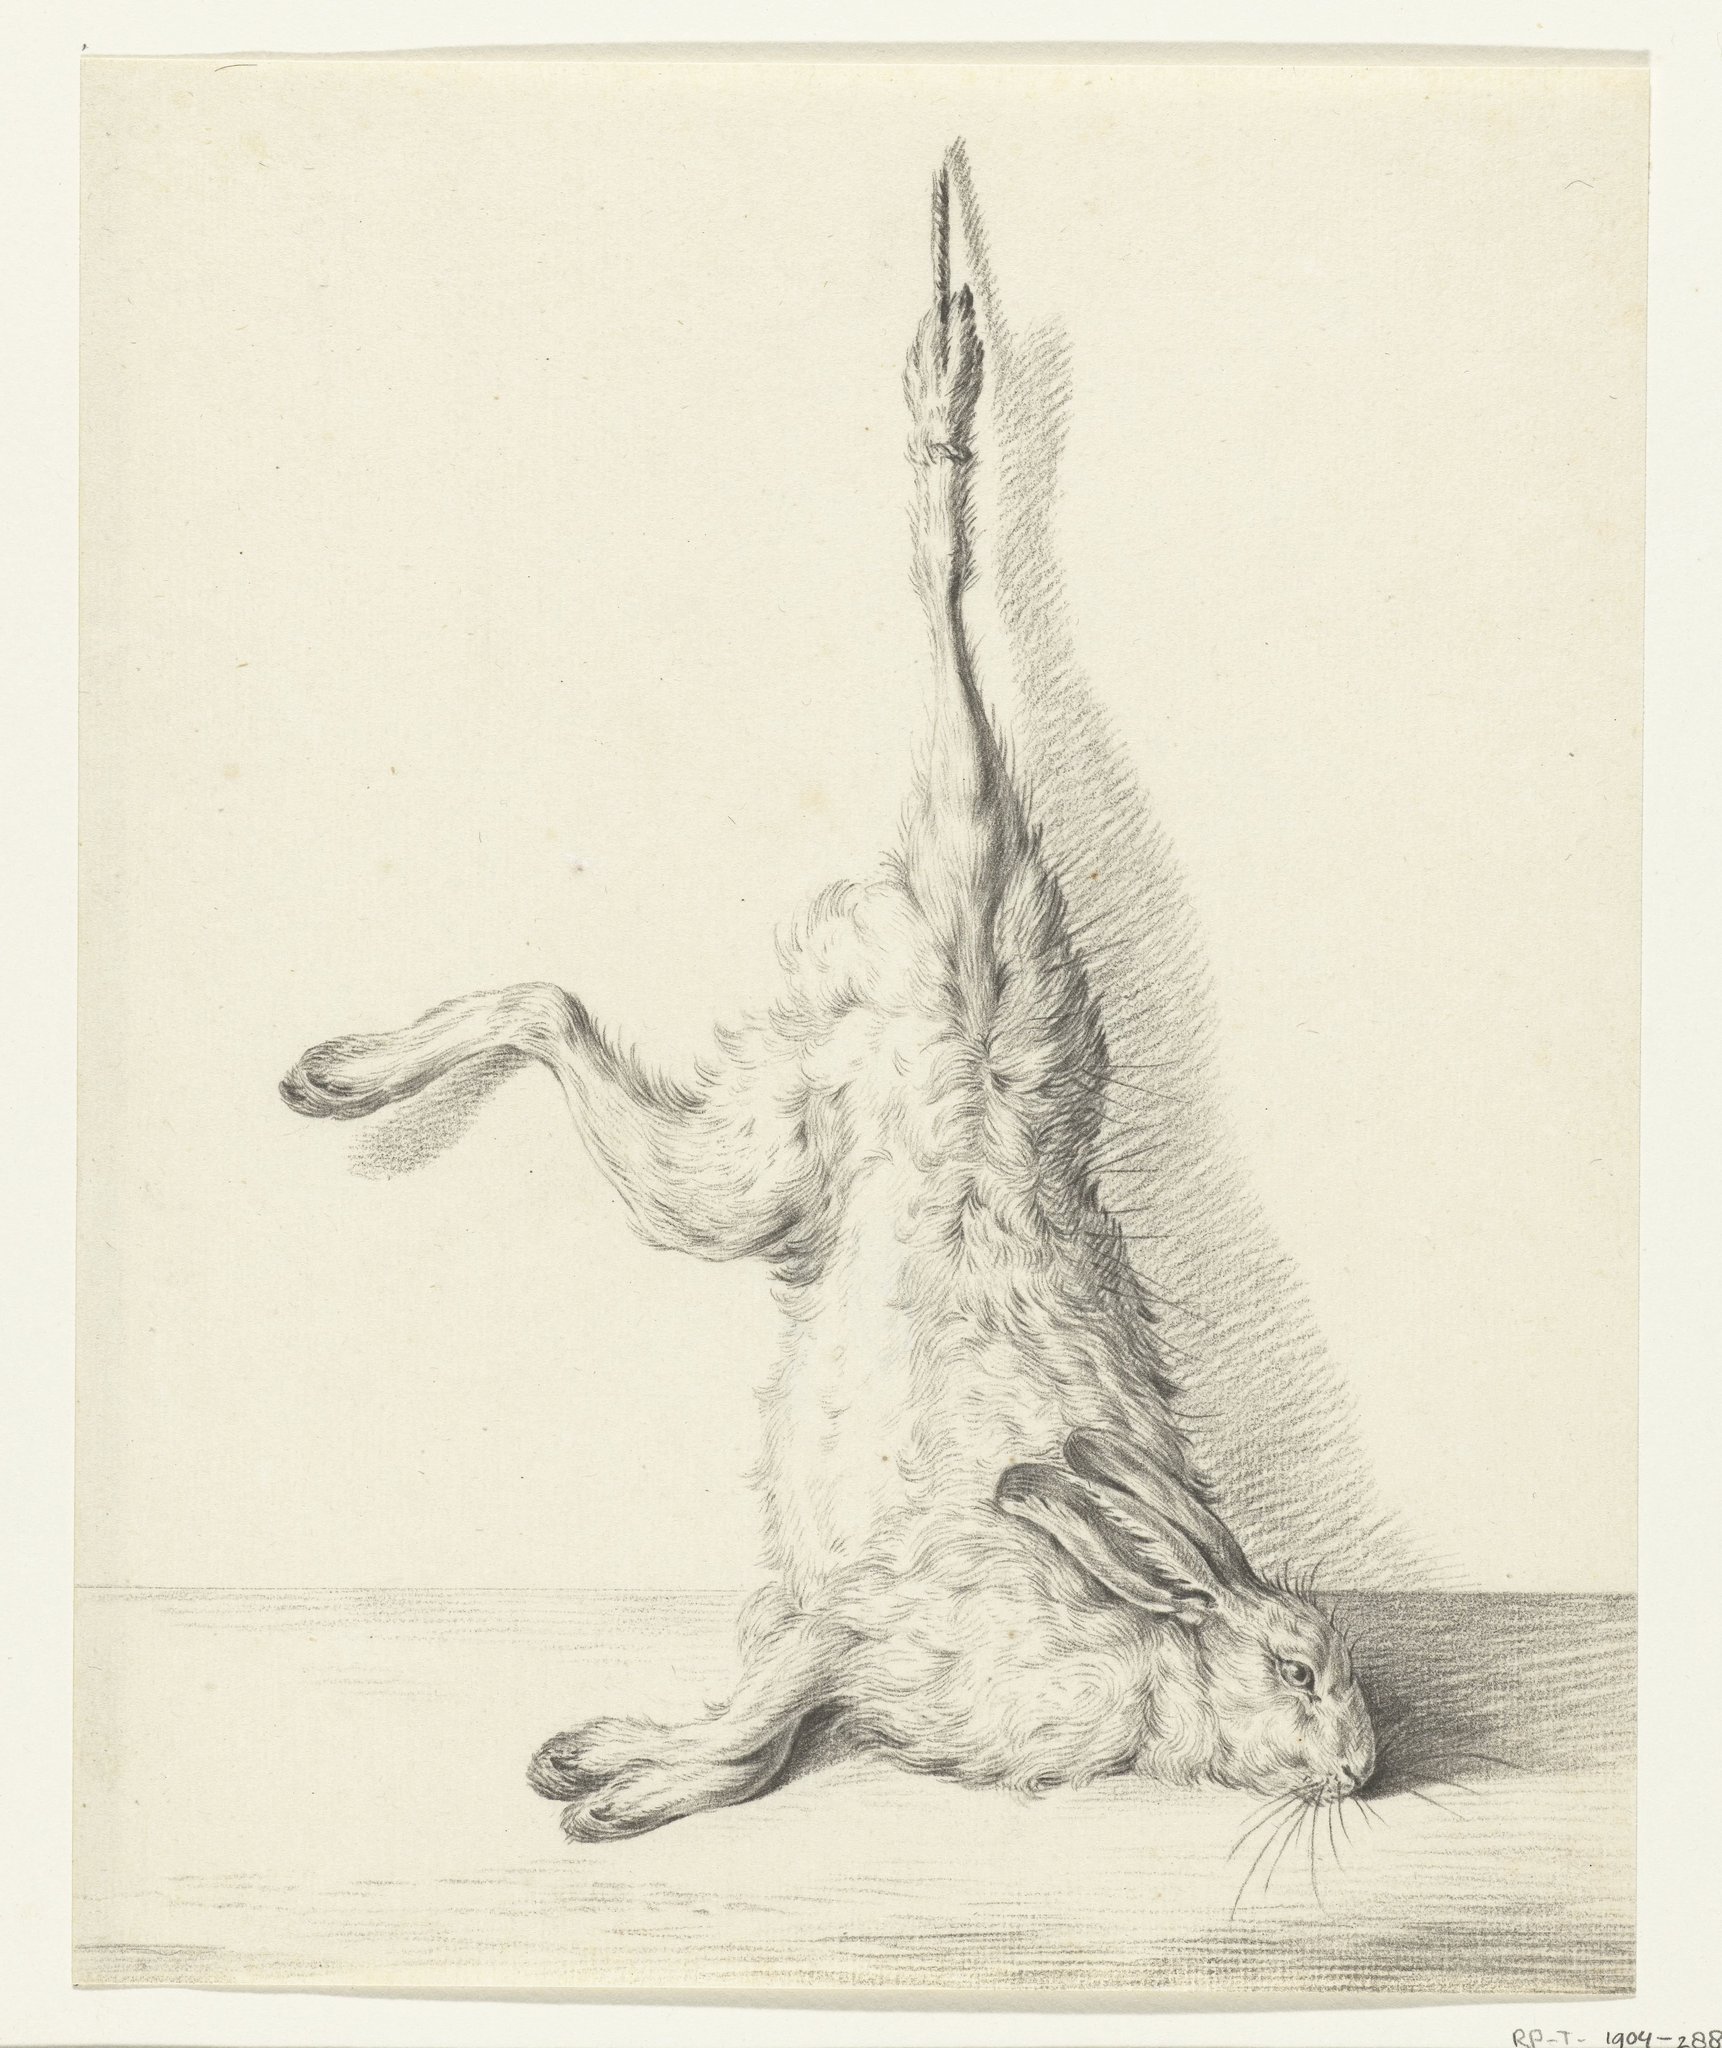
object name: drawing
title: Dode haas, hangend van een achterpoot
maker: jean bernard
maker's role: draughtsman, print maker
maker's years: 1765-1833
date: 1775-1833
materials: chalk, paper, pencil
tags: rodents: hare